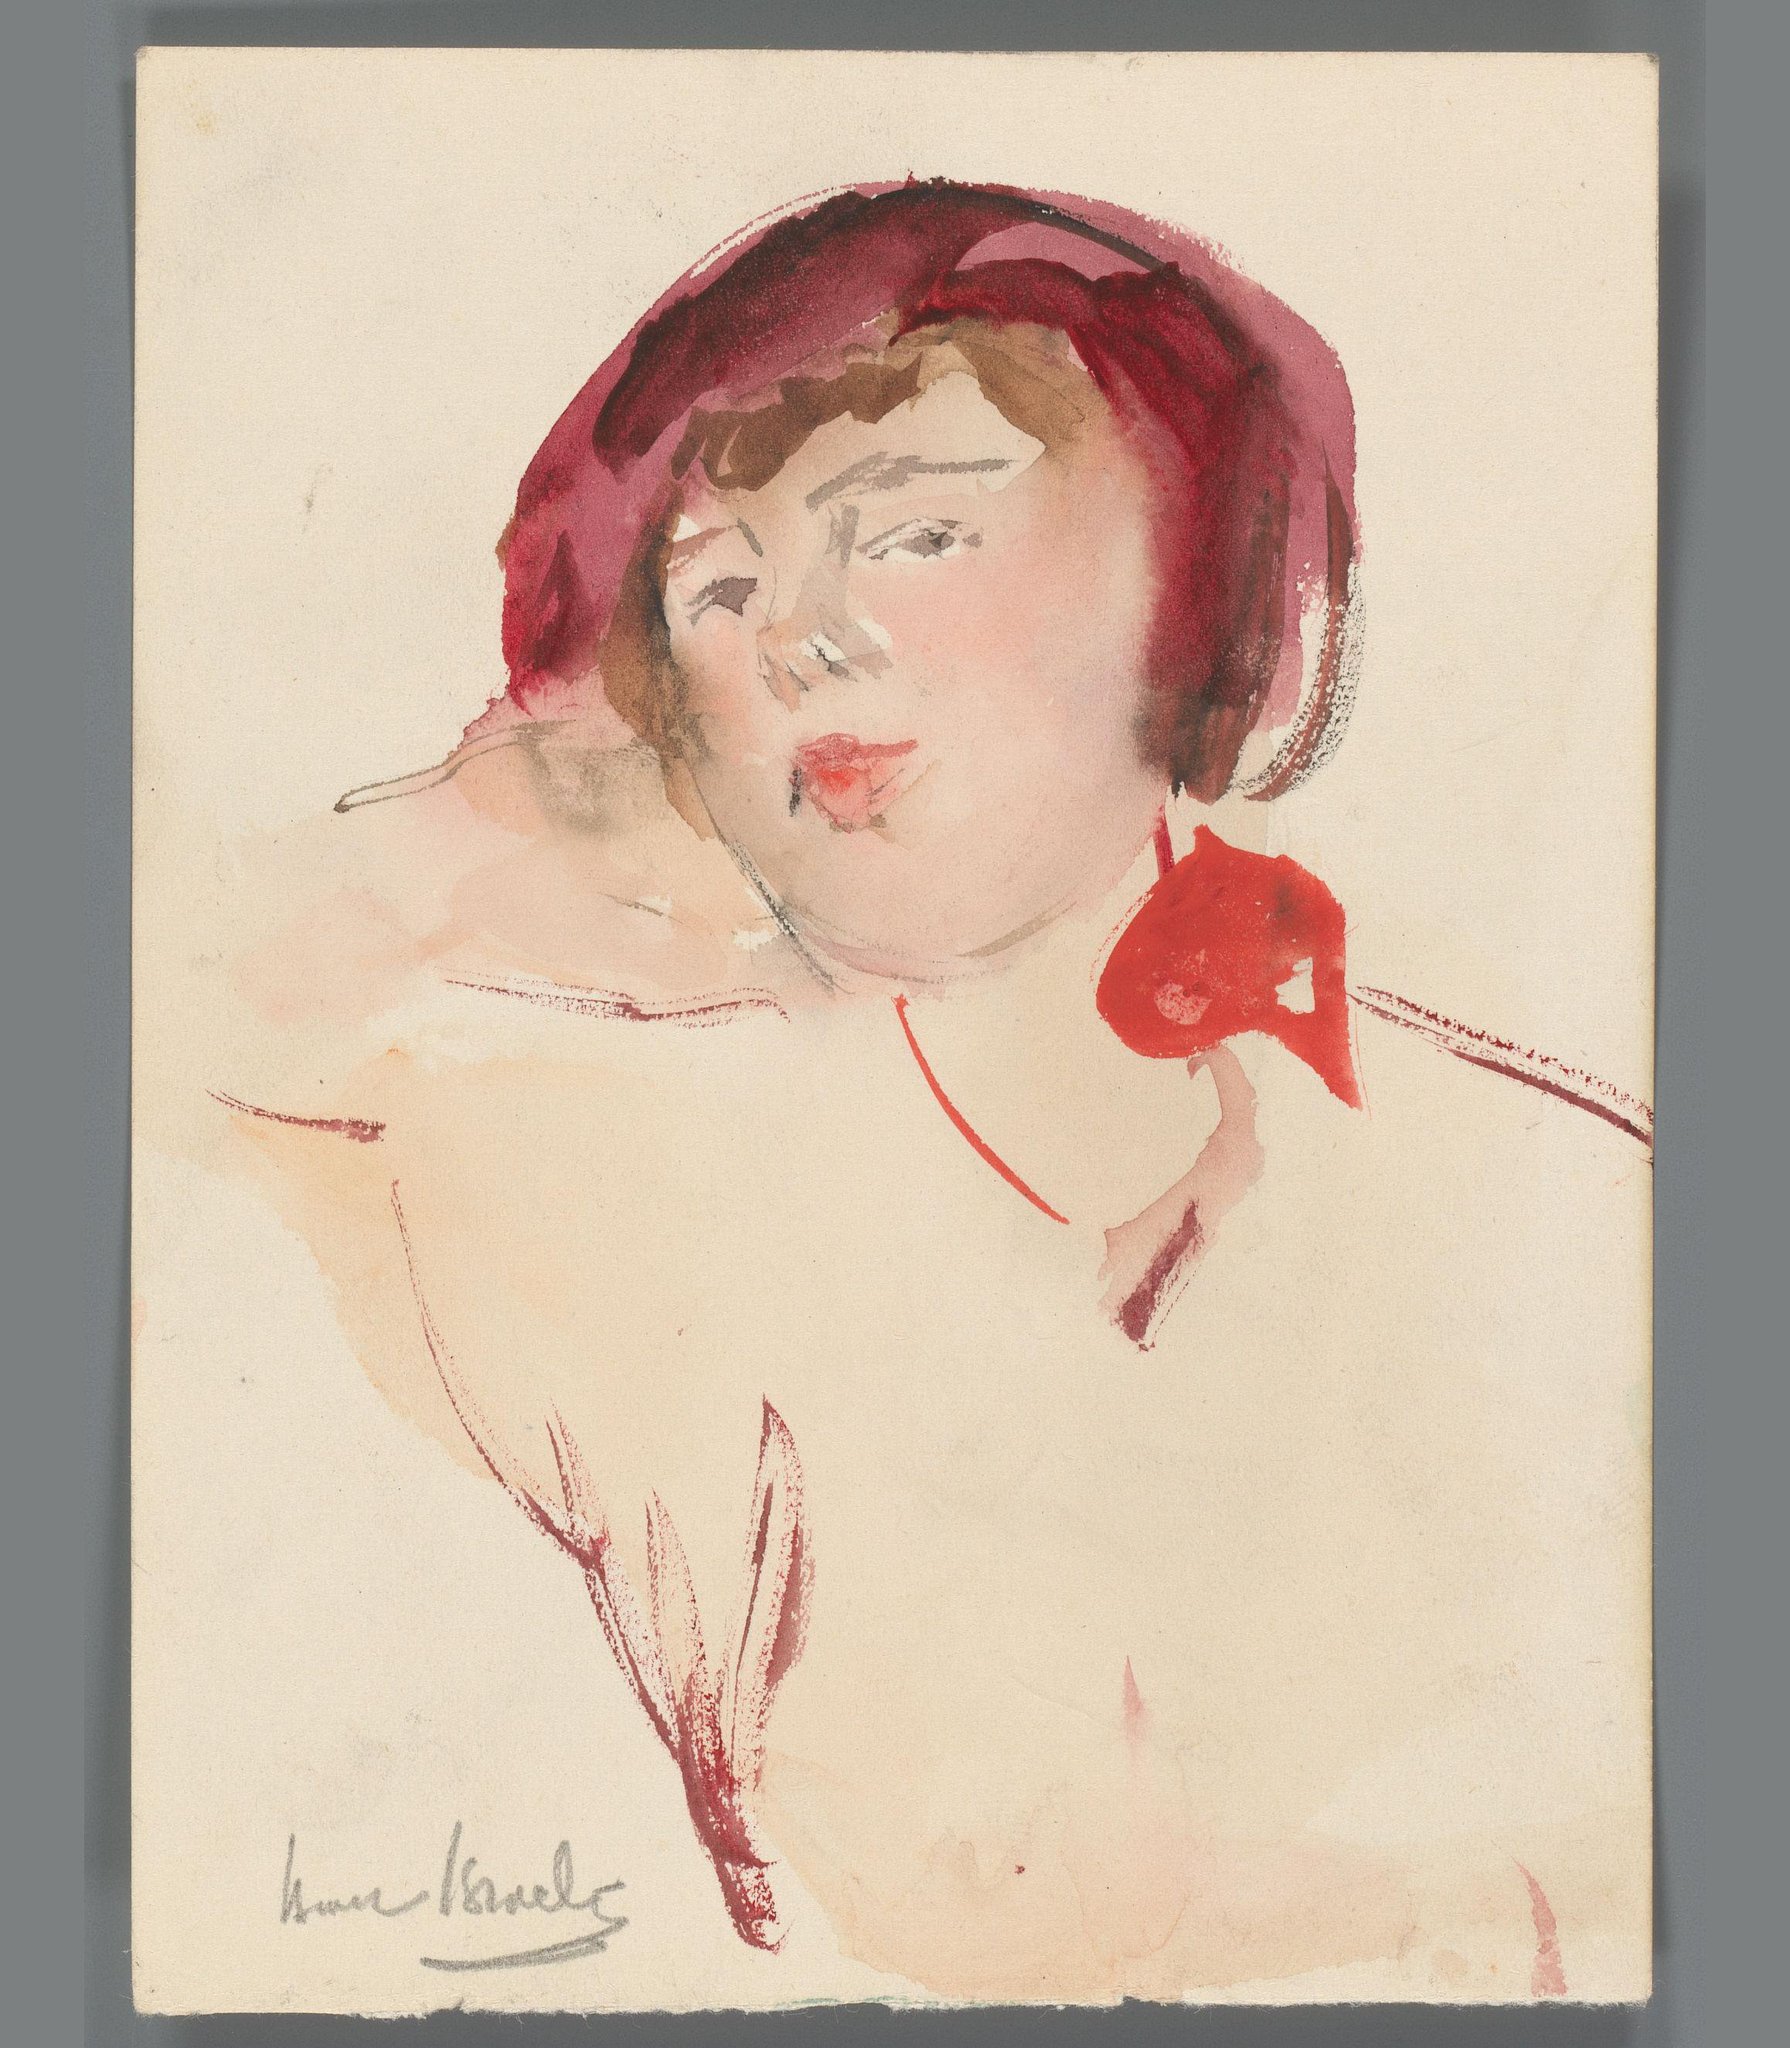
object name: drawing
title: Portret van een onbekende vrouw met hoed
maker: isaac israels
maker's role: draughtsman, painter, print maker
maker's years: 1865-1934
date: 1894-1919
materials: paper, watercolor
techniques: brush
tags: female sex; woman, head-gear: hat